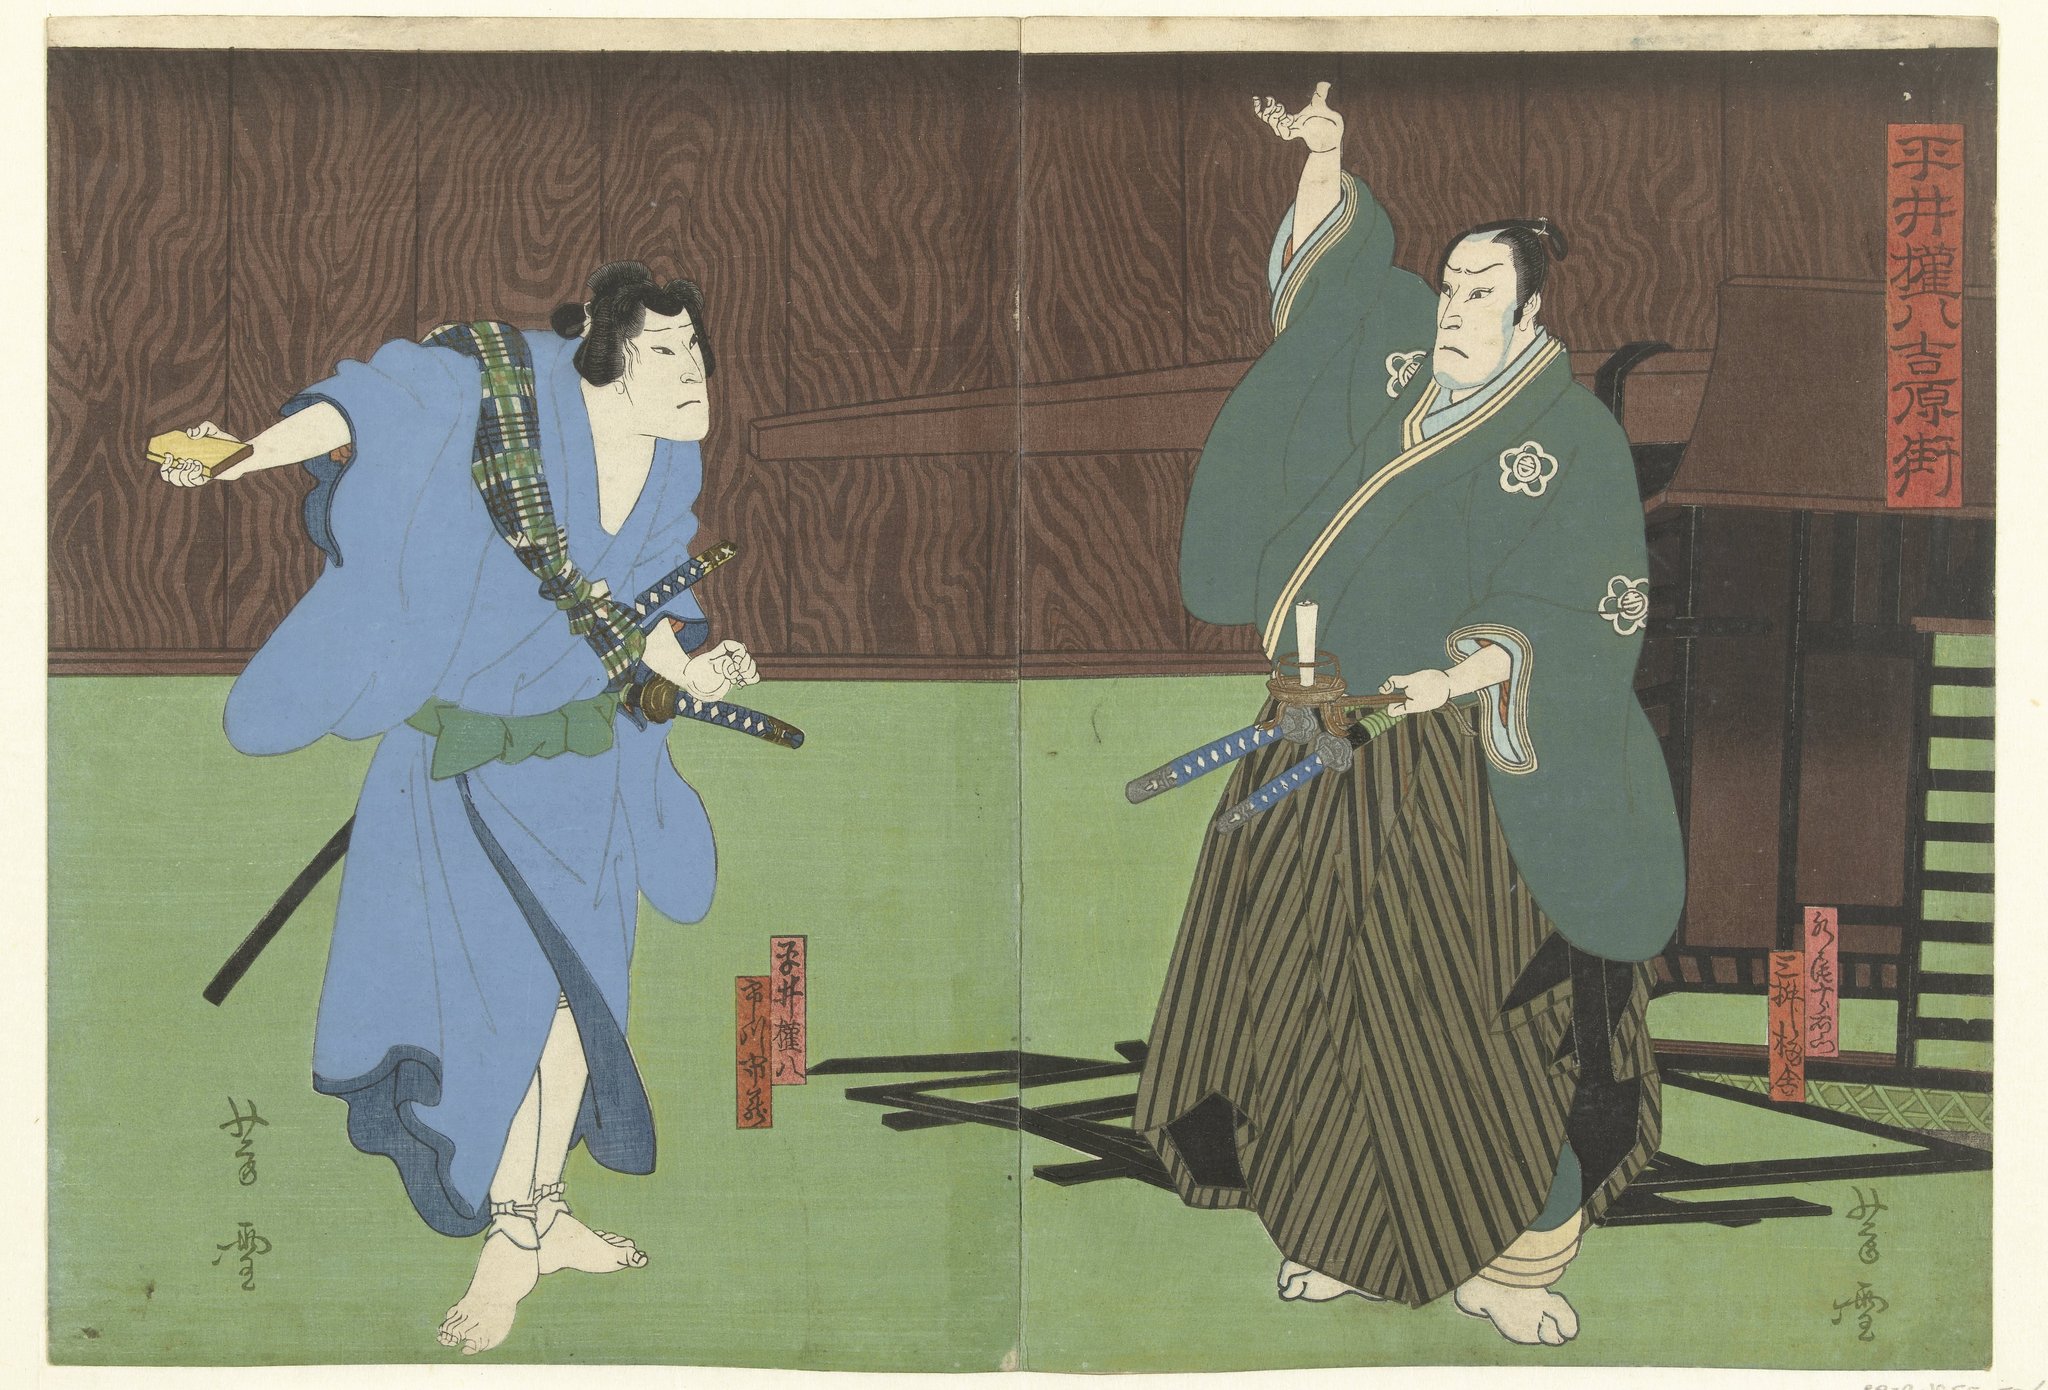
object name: diptych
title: Hirai Gonpachi Yoshiwaramachi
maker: mori yoshiyuki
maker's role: print maker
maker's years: 1835-1879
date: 1860-1870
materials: paper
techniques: woodcut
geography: osaka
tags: adult man (+ two persons), group of actors, troupe; actors on the stage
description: De acteur Mimasu Baisha in de rol van Mizuo Juroemon, met kandelaar in linker hand, tegenover Ichikawa Ichizo III als Shirai Gompachi.